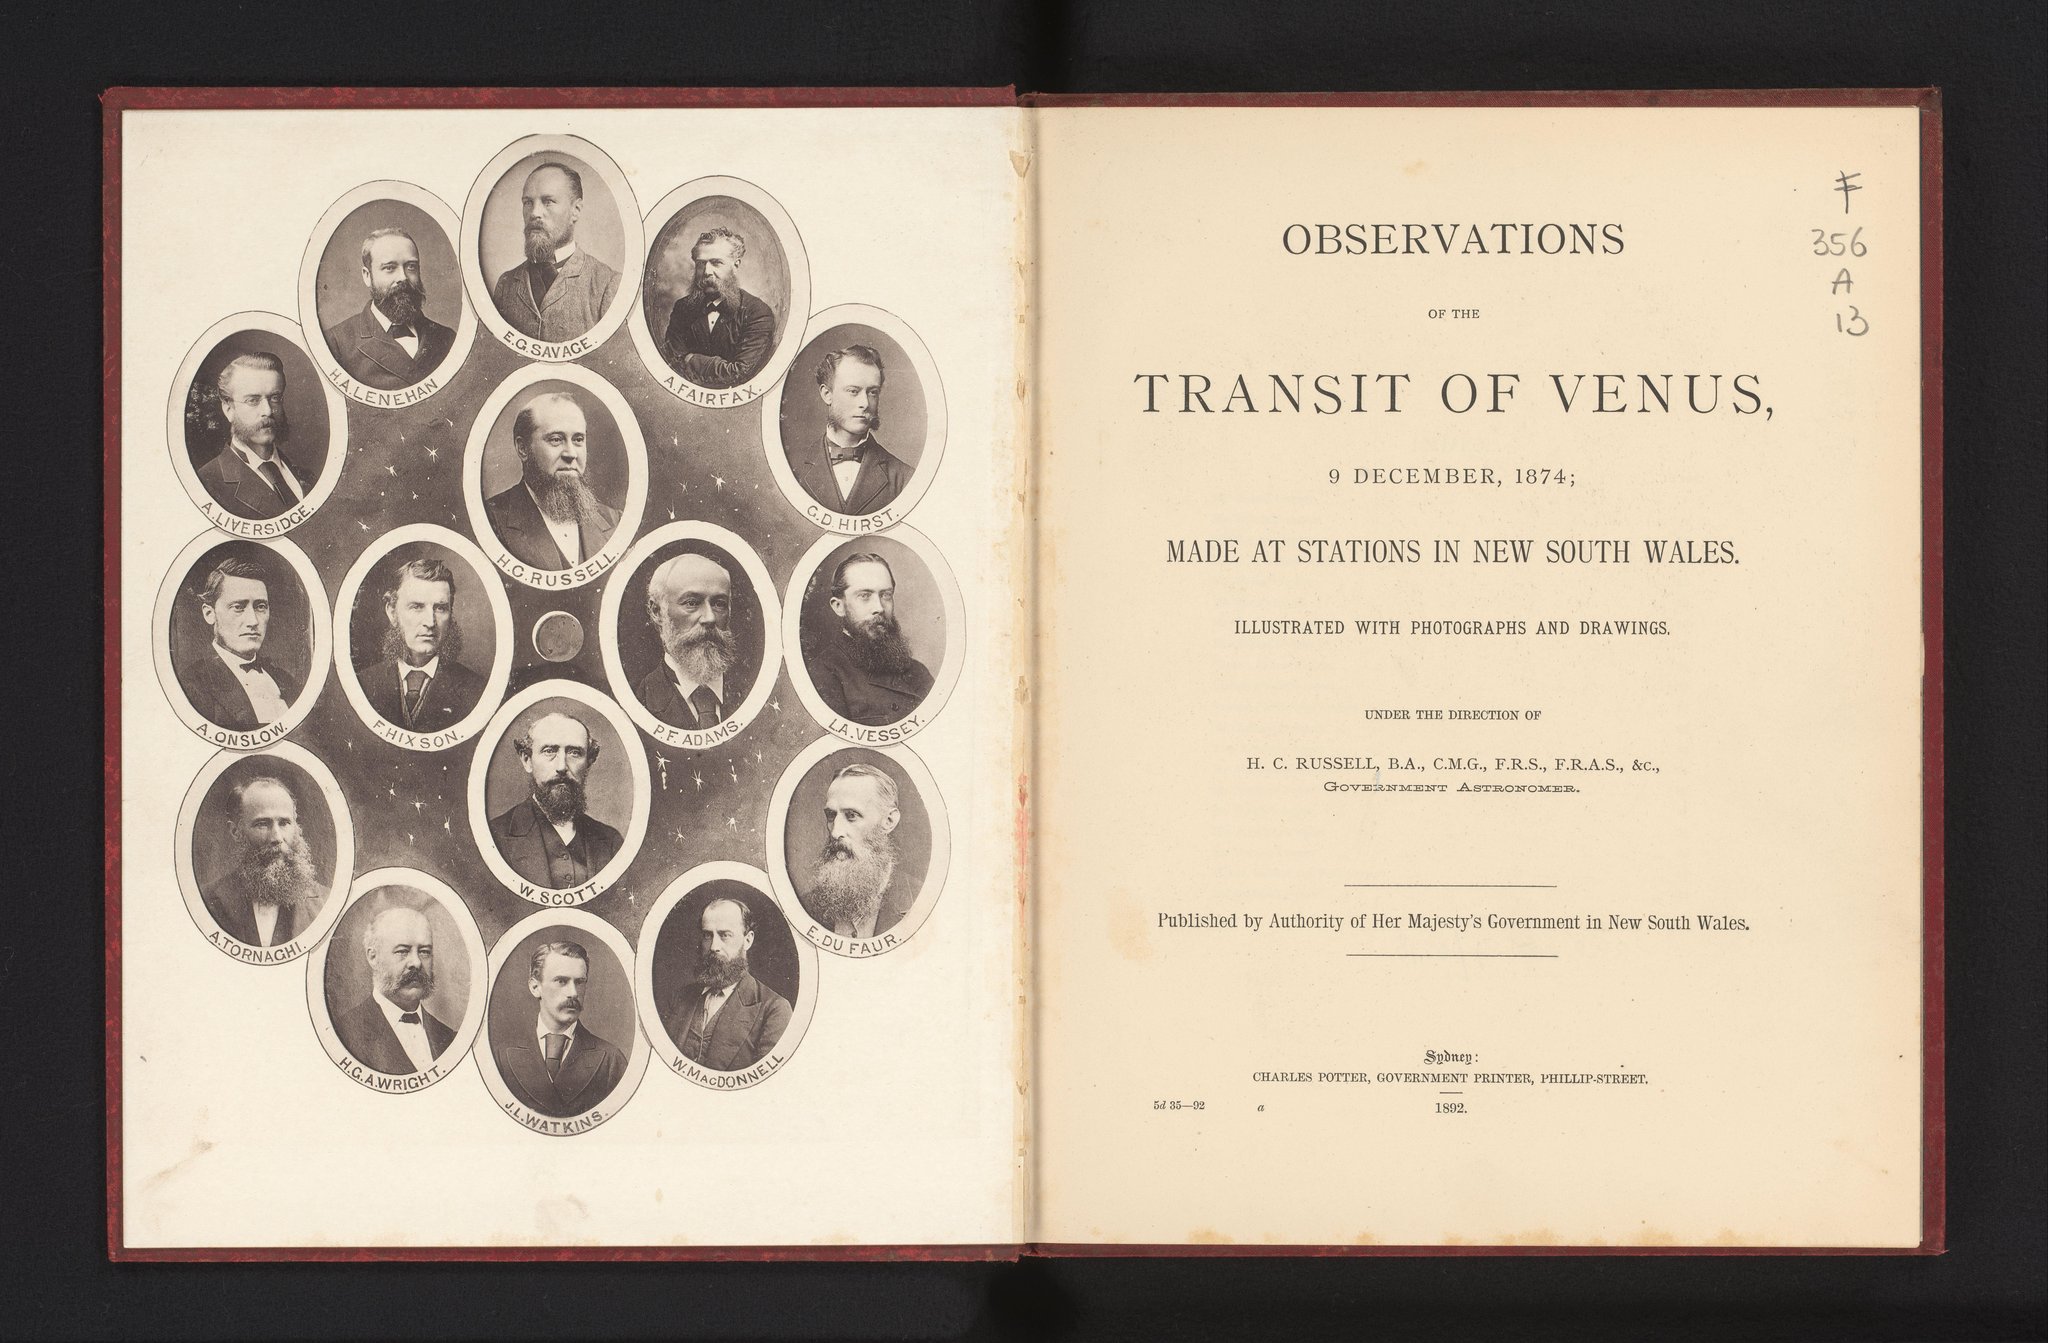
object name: book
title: Observations of the transit of Venus, 9 December, 1874 made at stations in New South Wales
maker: charles potter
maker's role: publisher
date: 1892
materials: cardboard, linen, paper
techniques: photograph, lithograph, printing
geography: sydney